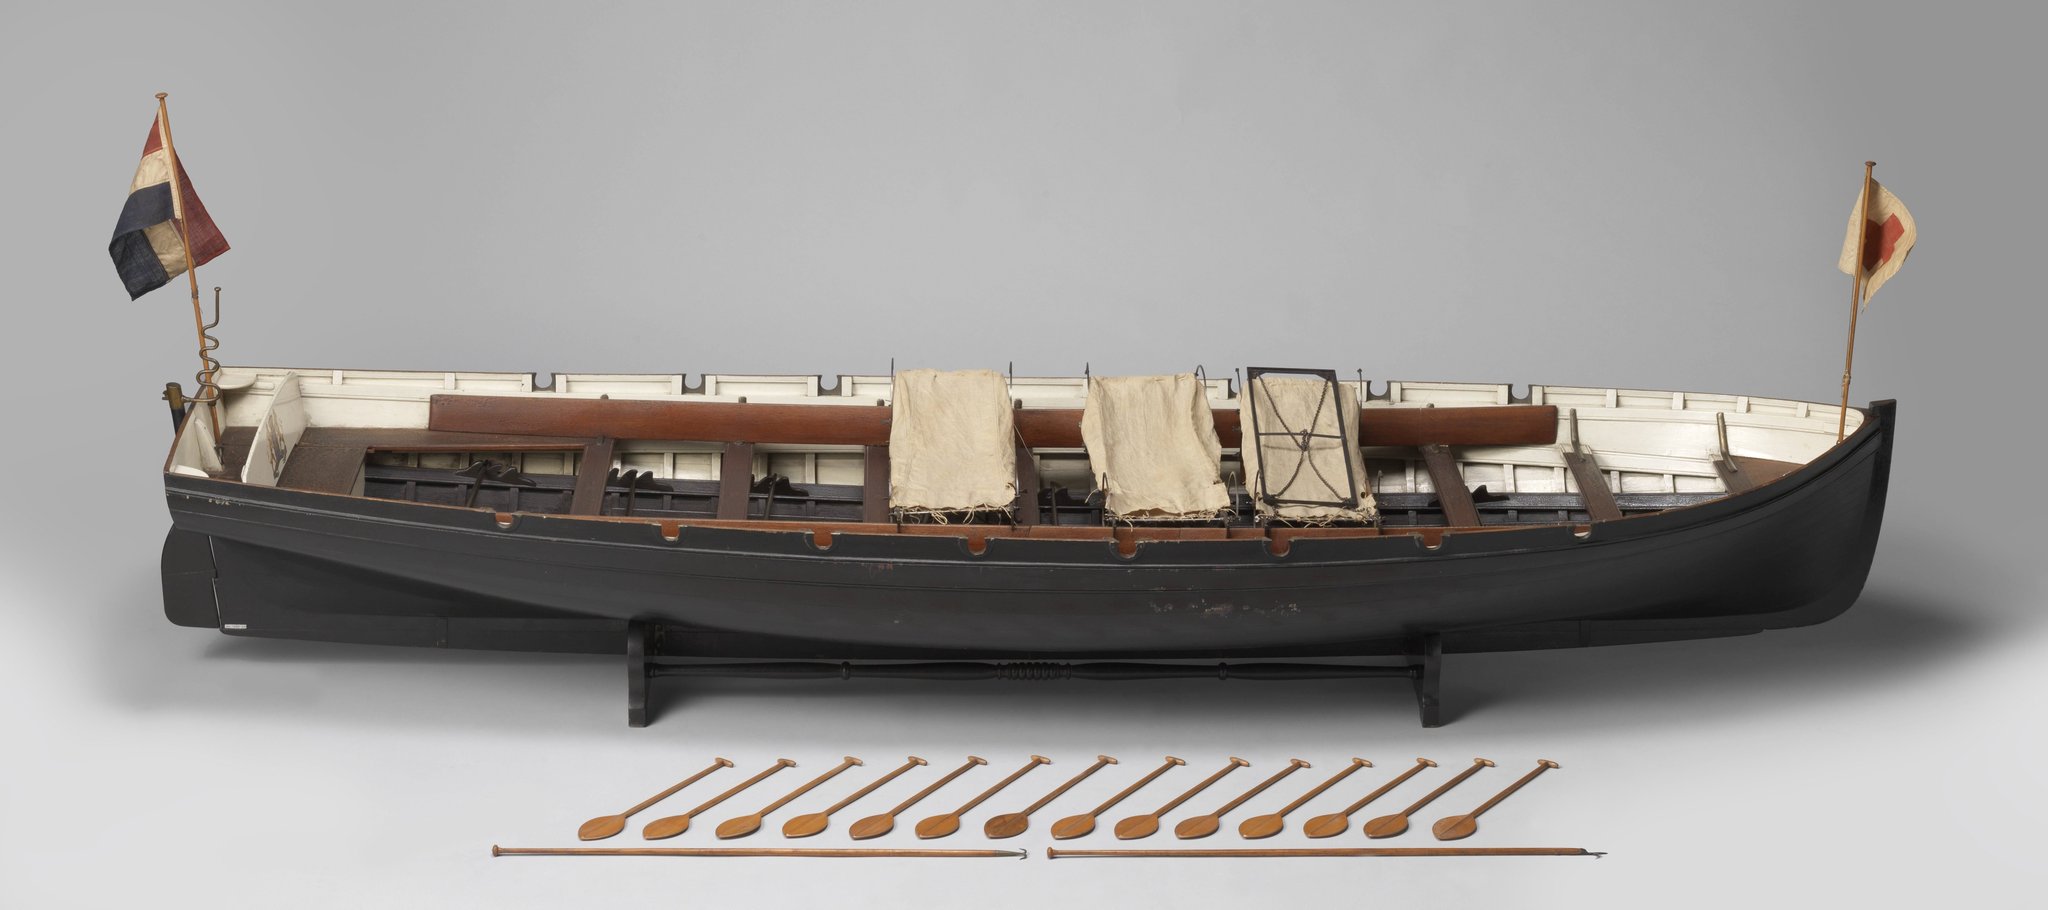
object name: ship model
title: Model of a Hospital Launch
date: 1877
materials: brass, iron, fiber, textile, wood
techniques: polychromy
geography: den helder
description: Gepolychromeerd spantmodel, uitgerust met drie brancards, op een standaard. Het is een gladboordige dubbelriems sloep van zestien riemen met platte spiegel, de zeeg naar beide uiteinden oplopend, een rondspant met dubbele kiel. Het heeft acht roeidoften met spoorstokken en een open kajuit met het Rijkswapen tegen het zettebord geschilderd. Tegen het boeisel zijn in de lengte balken over de doften gelegd, waarop brancards dwars over de boot gelegd kunnen worden. De brancards bestaan uit twee houten stokken waartussen doek is gespannen, met ijzeren beslag; halfronde beugels doen dienst als poten. De uiteinden van de stokken kunnen teruggevouwen worden, waardoor ijzeren haken bloot komen, die over de balken op de doften vallen. De brancards zijn afgedekt met zeildoek, dat aan een kant door een beugel omhooggehouden wordt. Eén van de brancards heeft een hijsframe met kettingen. De boot is verder uitgerust met twaalf pagaaien, twee boothaken, een roer, een Nederlandse driekleur en een vlag met het Rode Kruis.